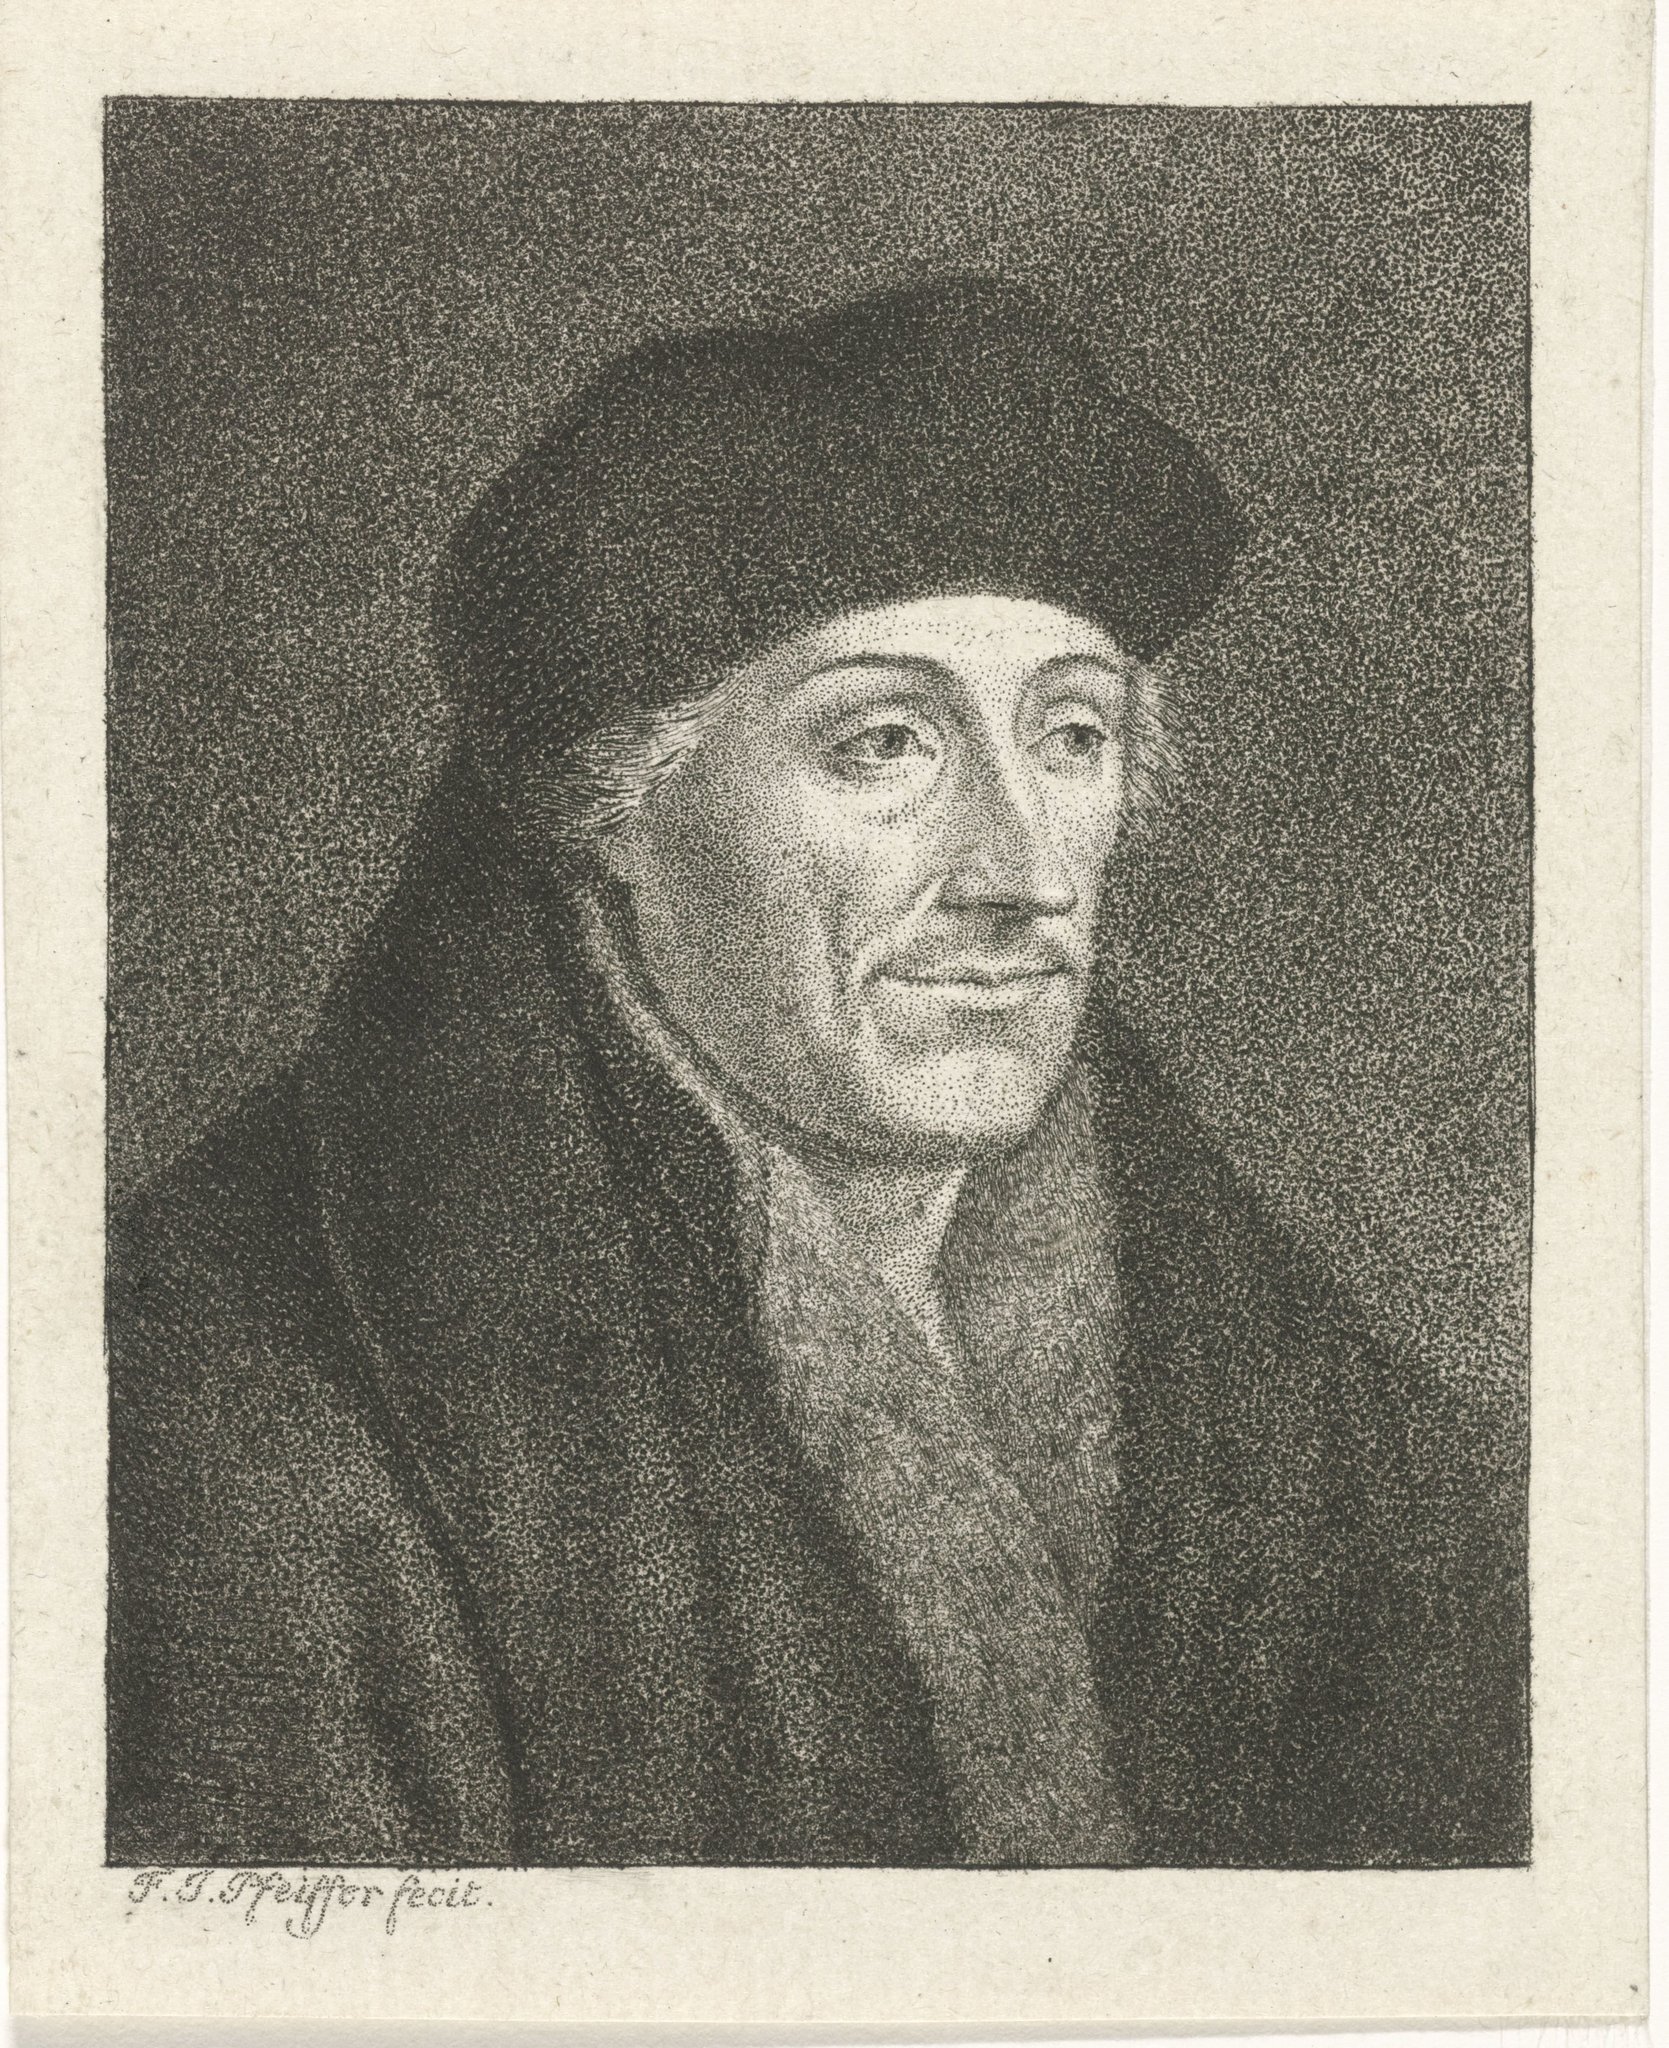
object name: print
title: Portret van Desiderius Erasmus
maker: françois joseph pfeiffer (i)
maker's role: print maker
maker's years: 1741-1807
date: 1751-1807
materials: paper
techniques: aquatint, etching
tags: rotterdam, desiderius erasmus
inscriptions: collector's mark: Lugt 2228